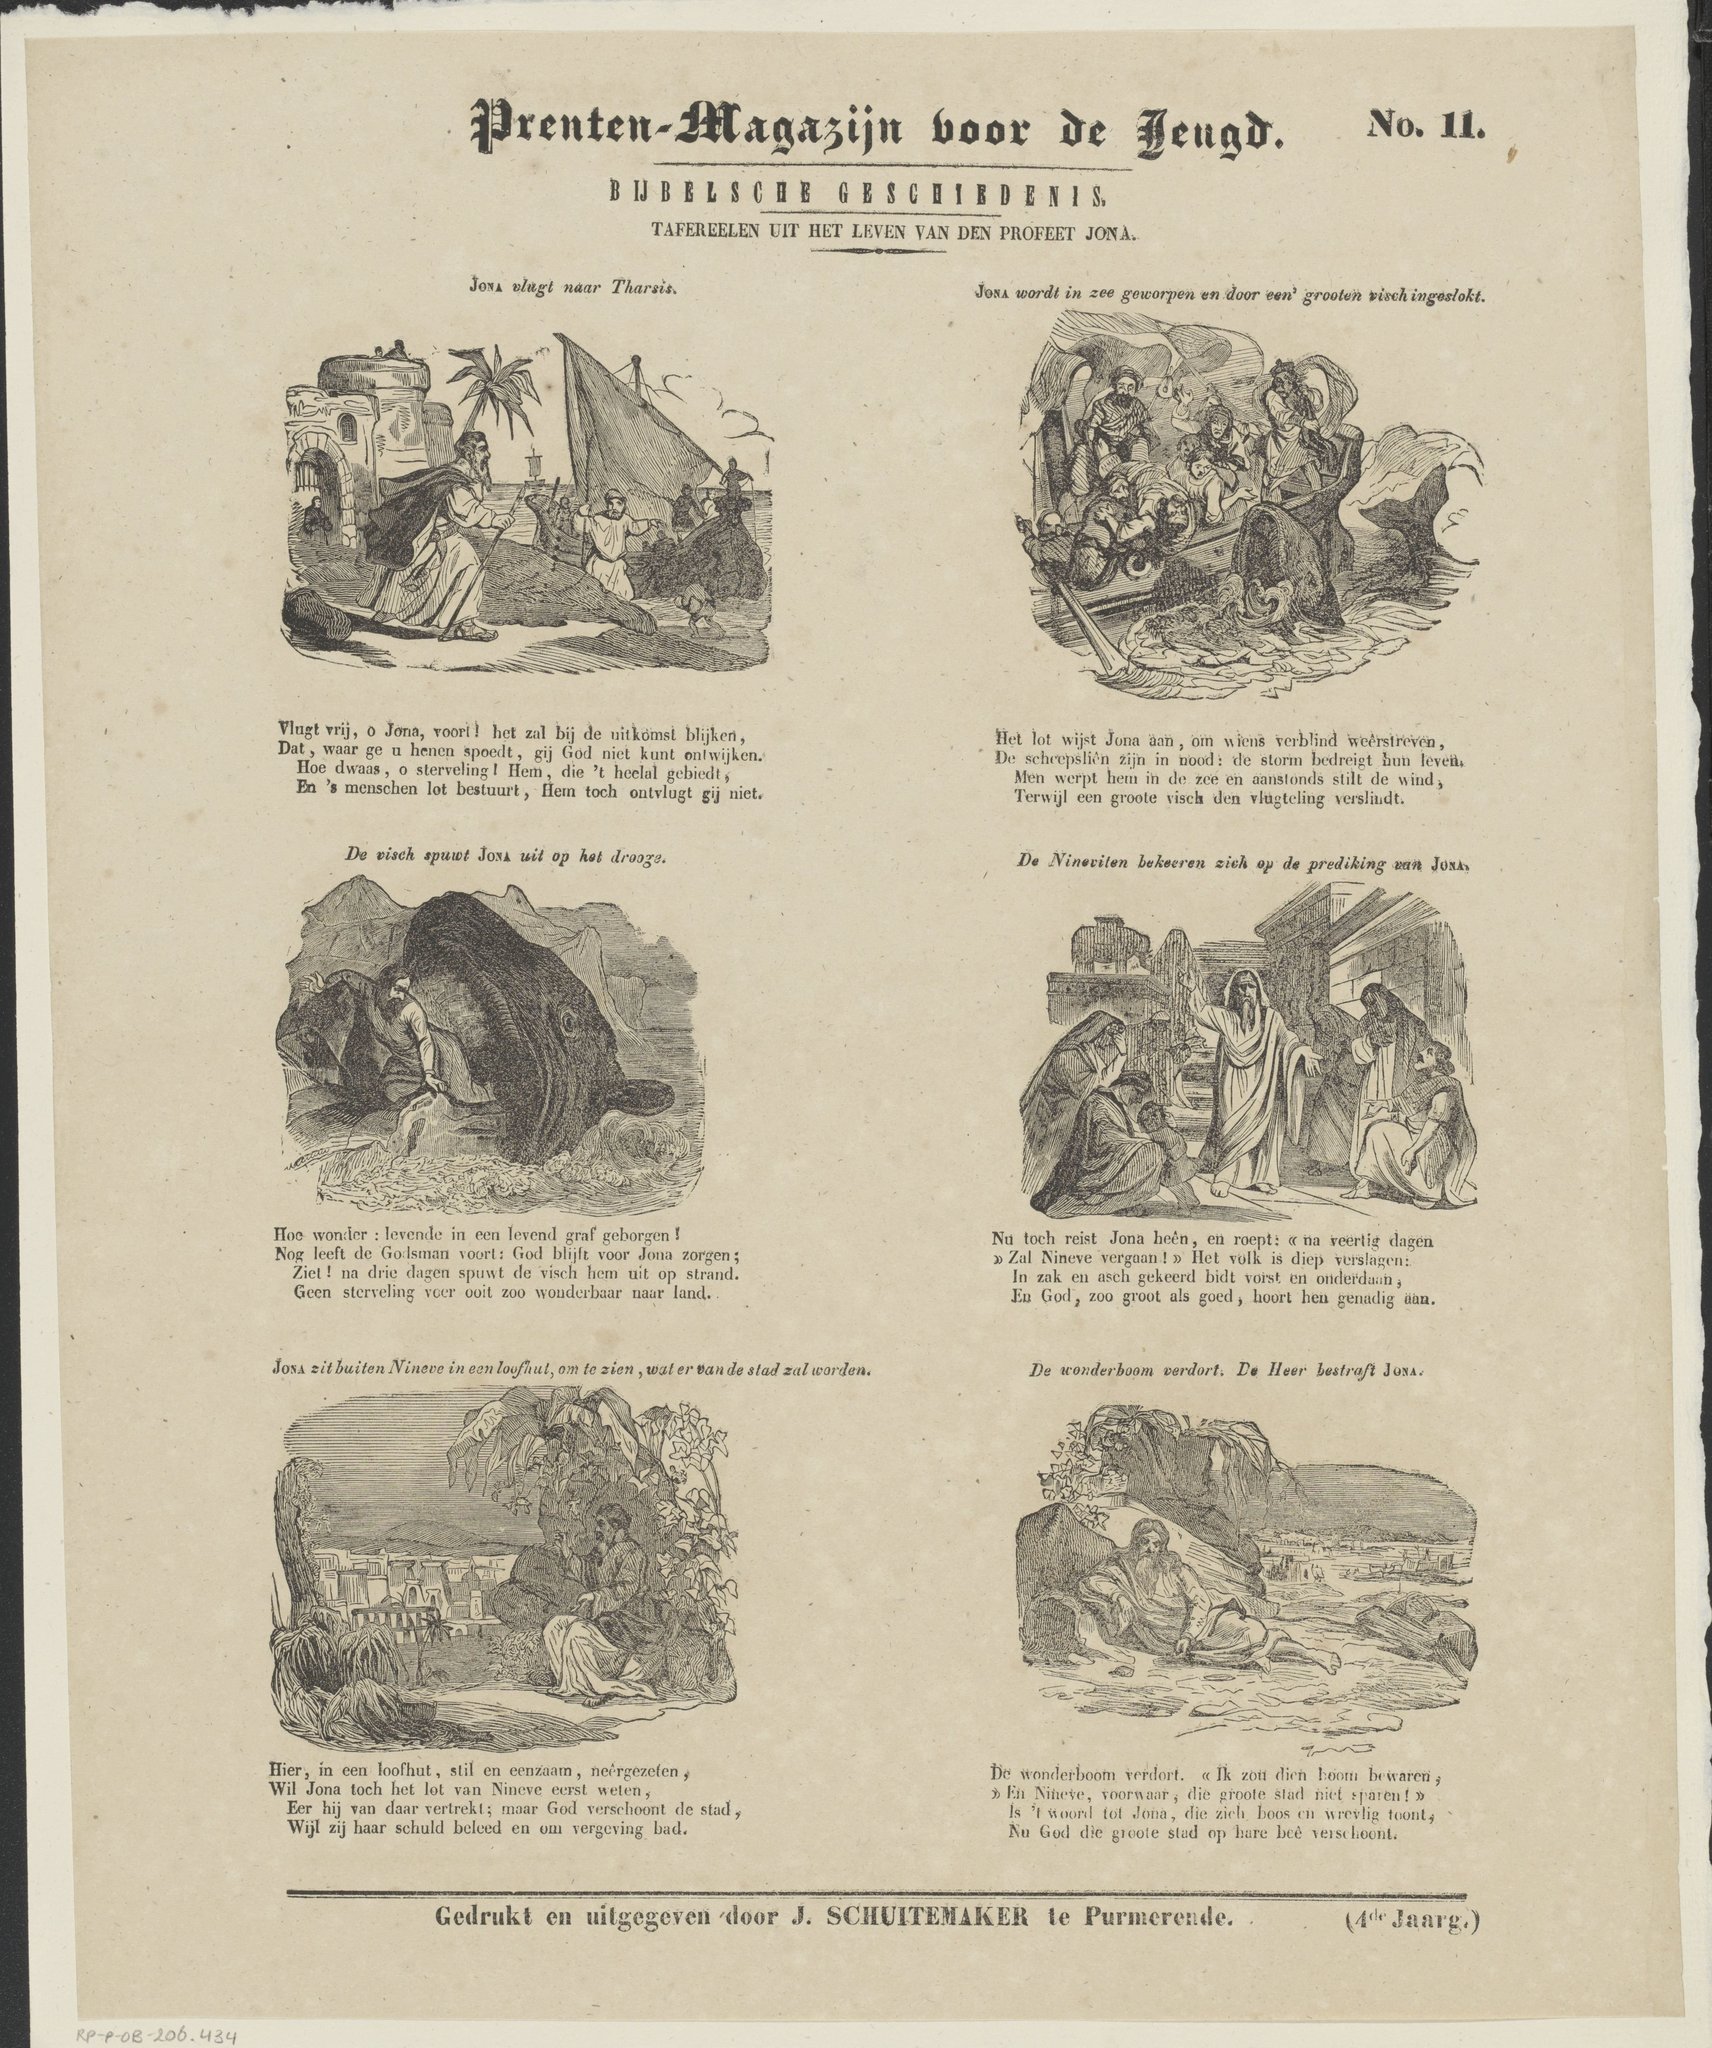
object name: print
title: Bijbelsche geschiedenis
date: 1845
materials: paper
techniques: letterpress printing, engraving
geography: netherlands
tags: the book of jonah, old testament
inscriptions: collector's mark: Lugt 2760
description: Blad met 6 voorstellingen uit het leven van de oudtestamentische profeet Jona. Boven elke voorstelling een titel en onder elke voorstelling een vierregelig vers. Genummerd rechtsboven: No. 11.